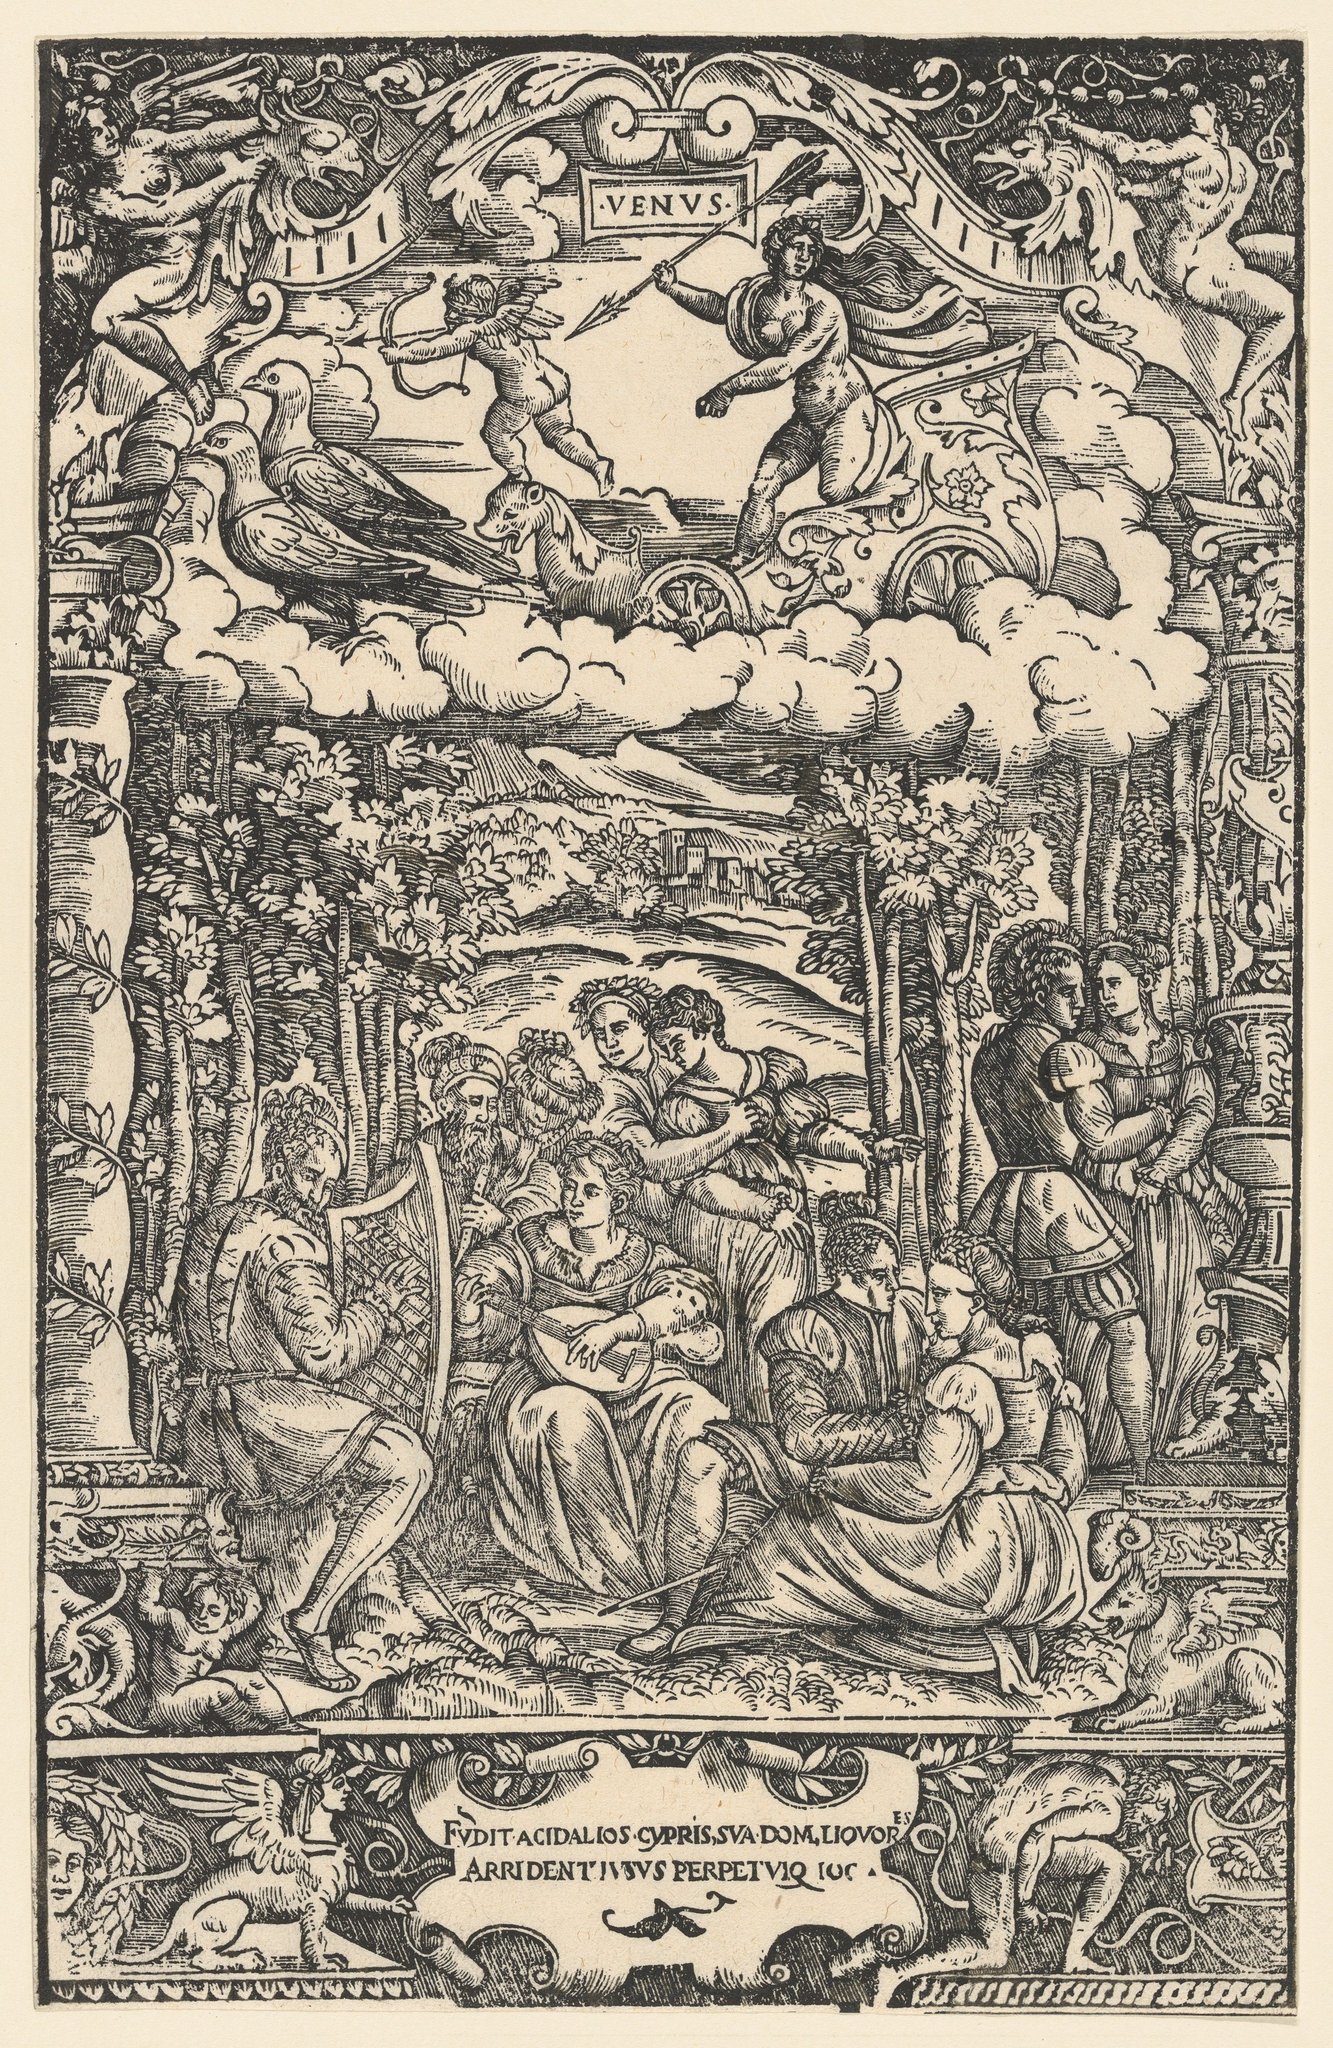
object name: print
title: The Dominion of Venus, from 'The Seven Planets'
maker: girolamo grandi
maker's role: artist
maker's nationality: italian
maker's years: 1530-1548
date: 1533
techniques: woodcut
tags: birds,men,women,venus